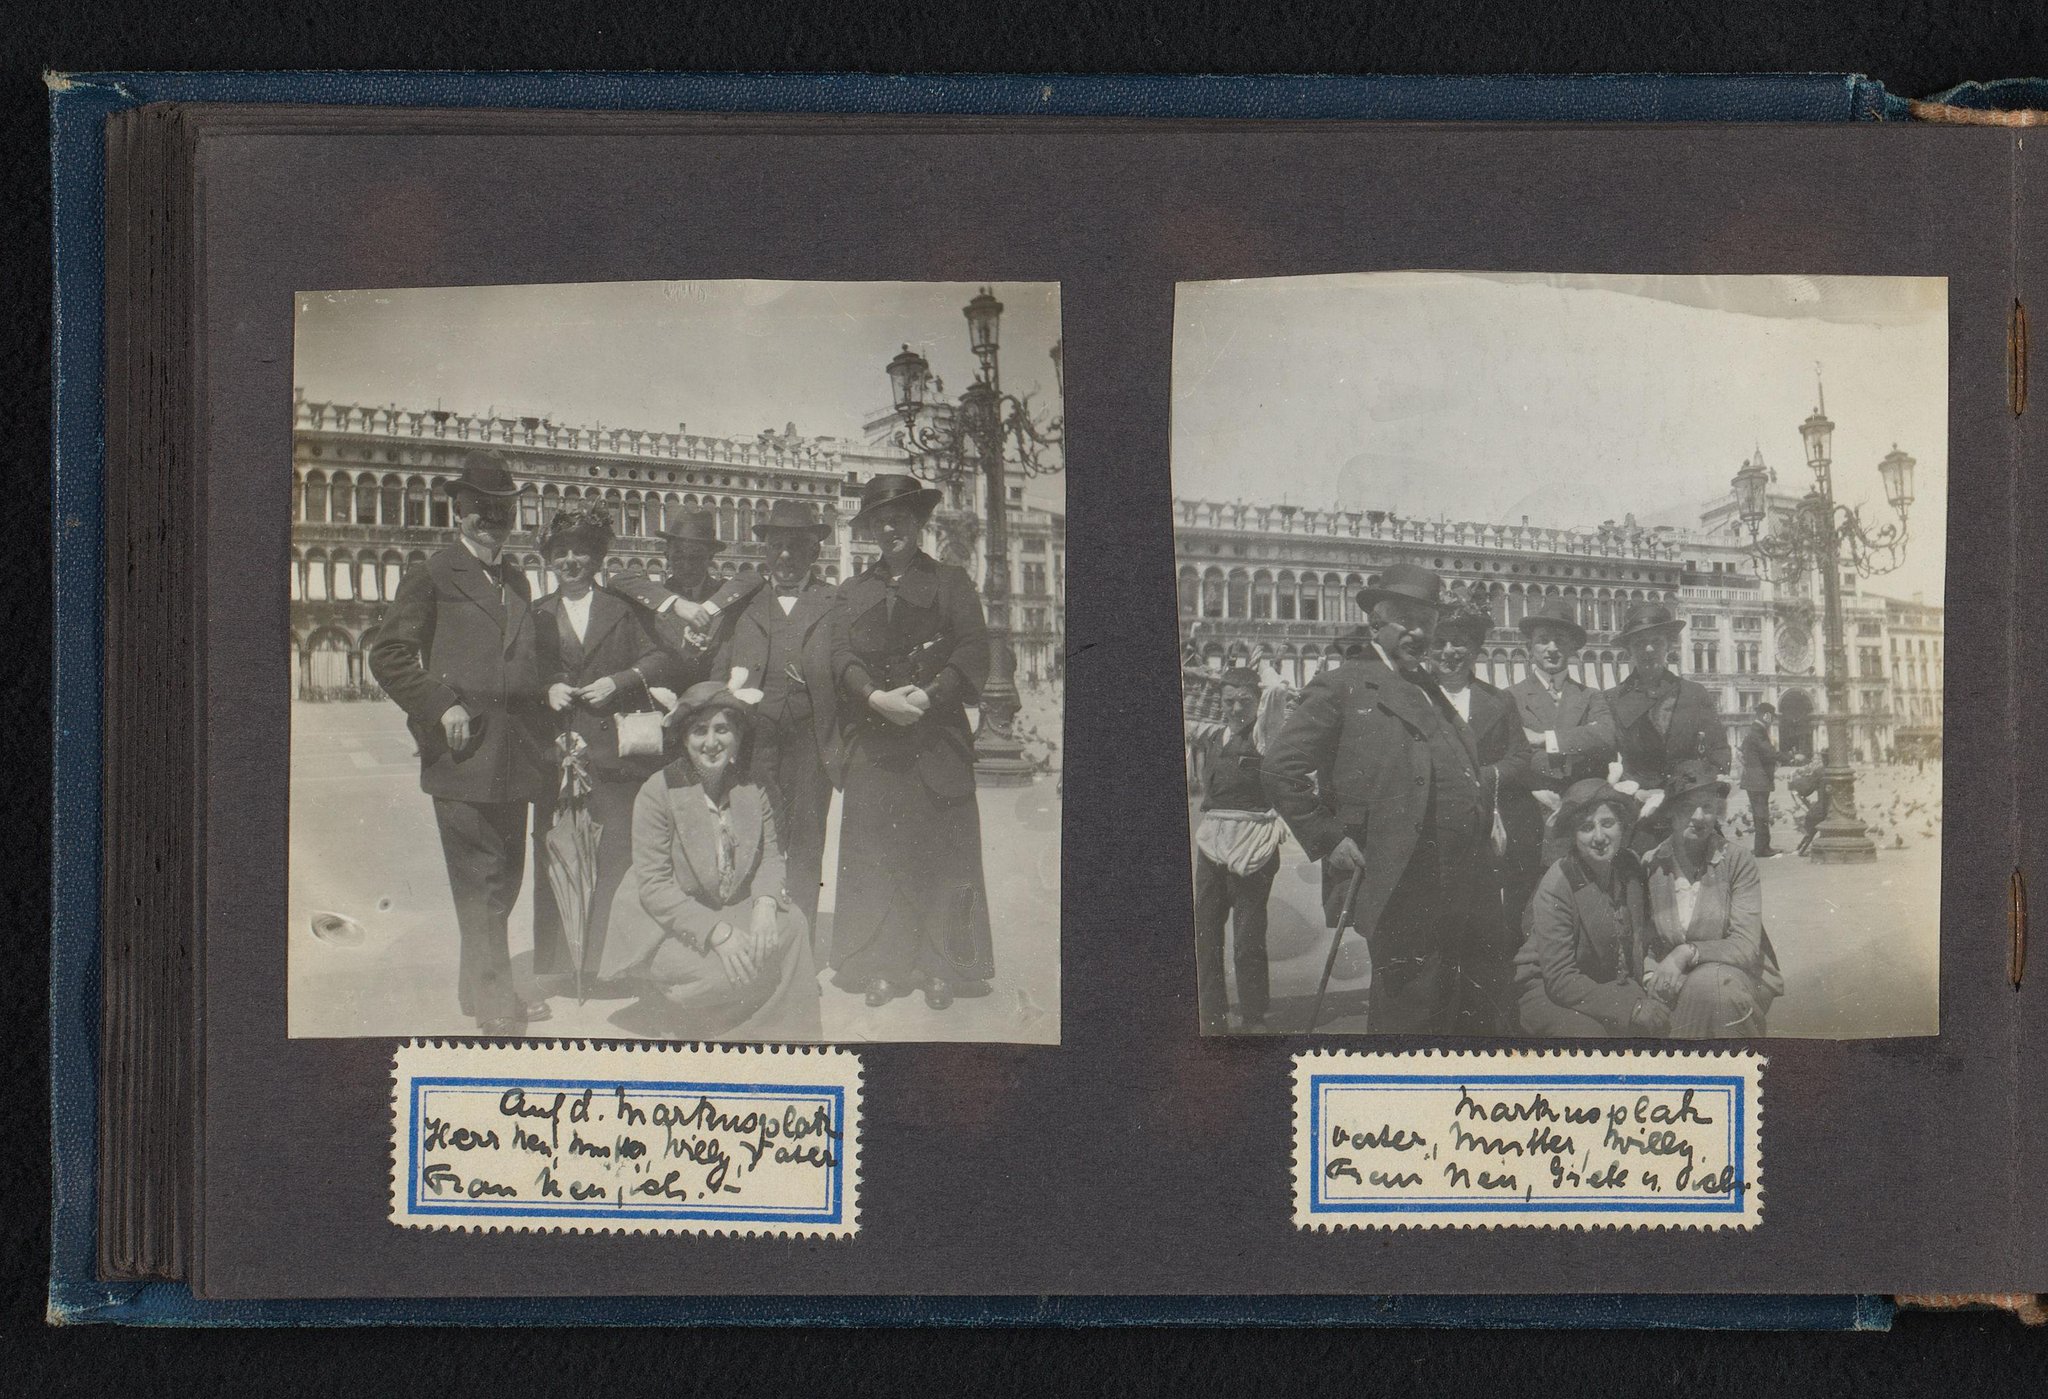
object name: photograph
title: De familie op het San Marcoplein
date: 1914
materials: paper, photographic support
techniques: gelatin silver print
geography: venice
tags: else wachenheimer-moos, willy moos, the family travelling, on holiday, tourism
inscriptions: inscription: ‘Auf d. Markusplatz / Herr Nen, mutter, Willy, Vater, Frau Nen, ich’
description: Albumblad met twee foto's van Else Moos met haar ouders en enkele andere familieleden op het San Marcoplein in Venetië. Onderdeel van het fotoalbum van Else Wachenheimer-Moos en haar broers Arthur en Willy Moos en anderen in de periode 1913-1918.